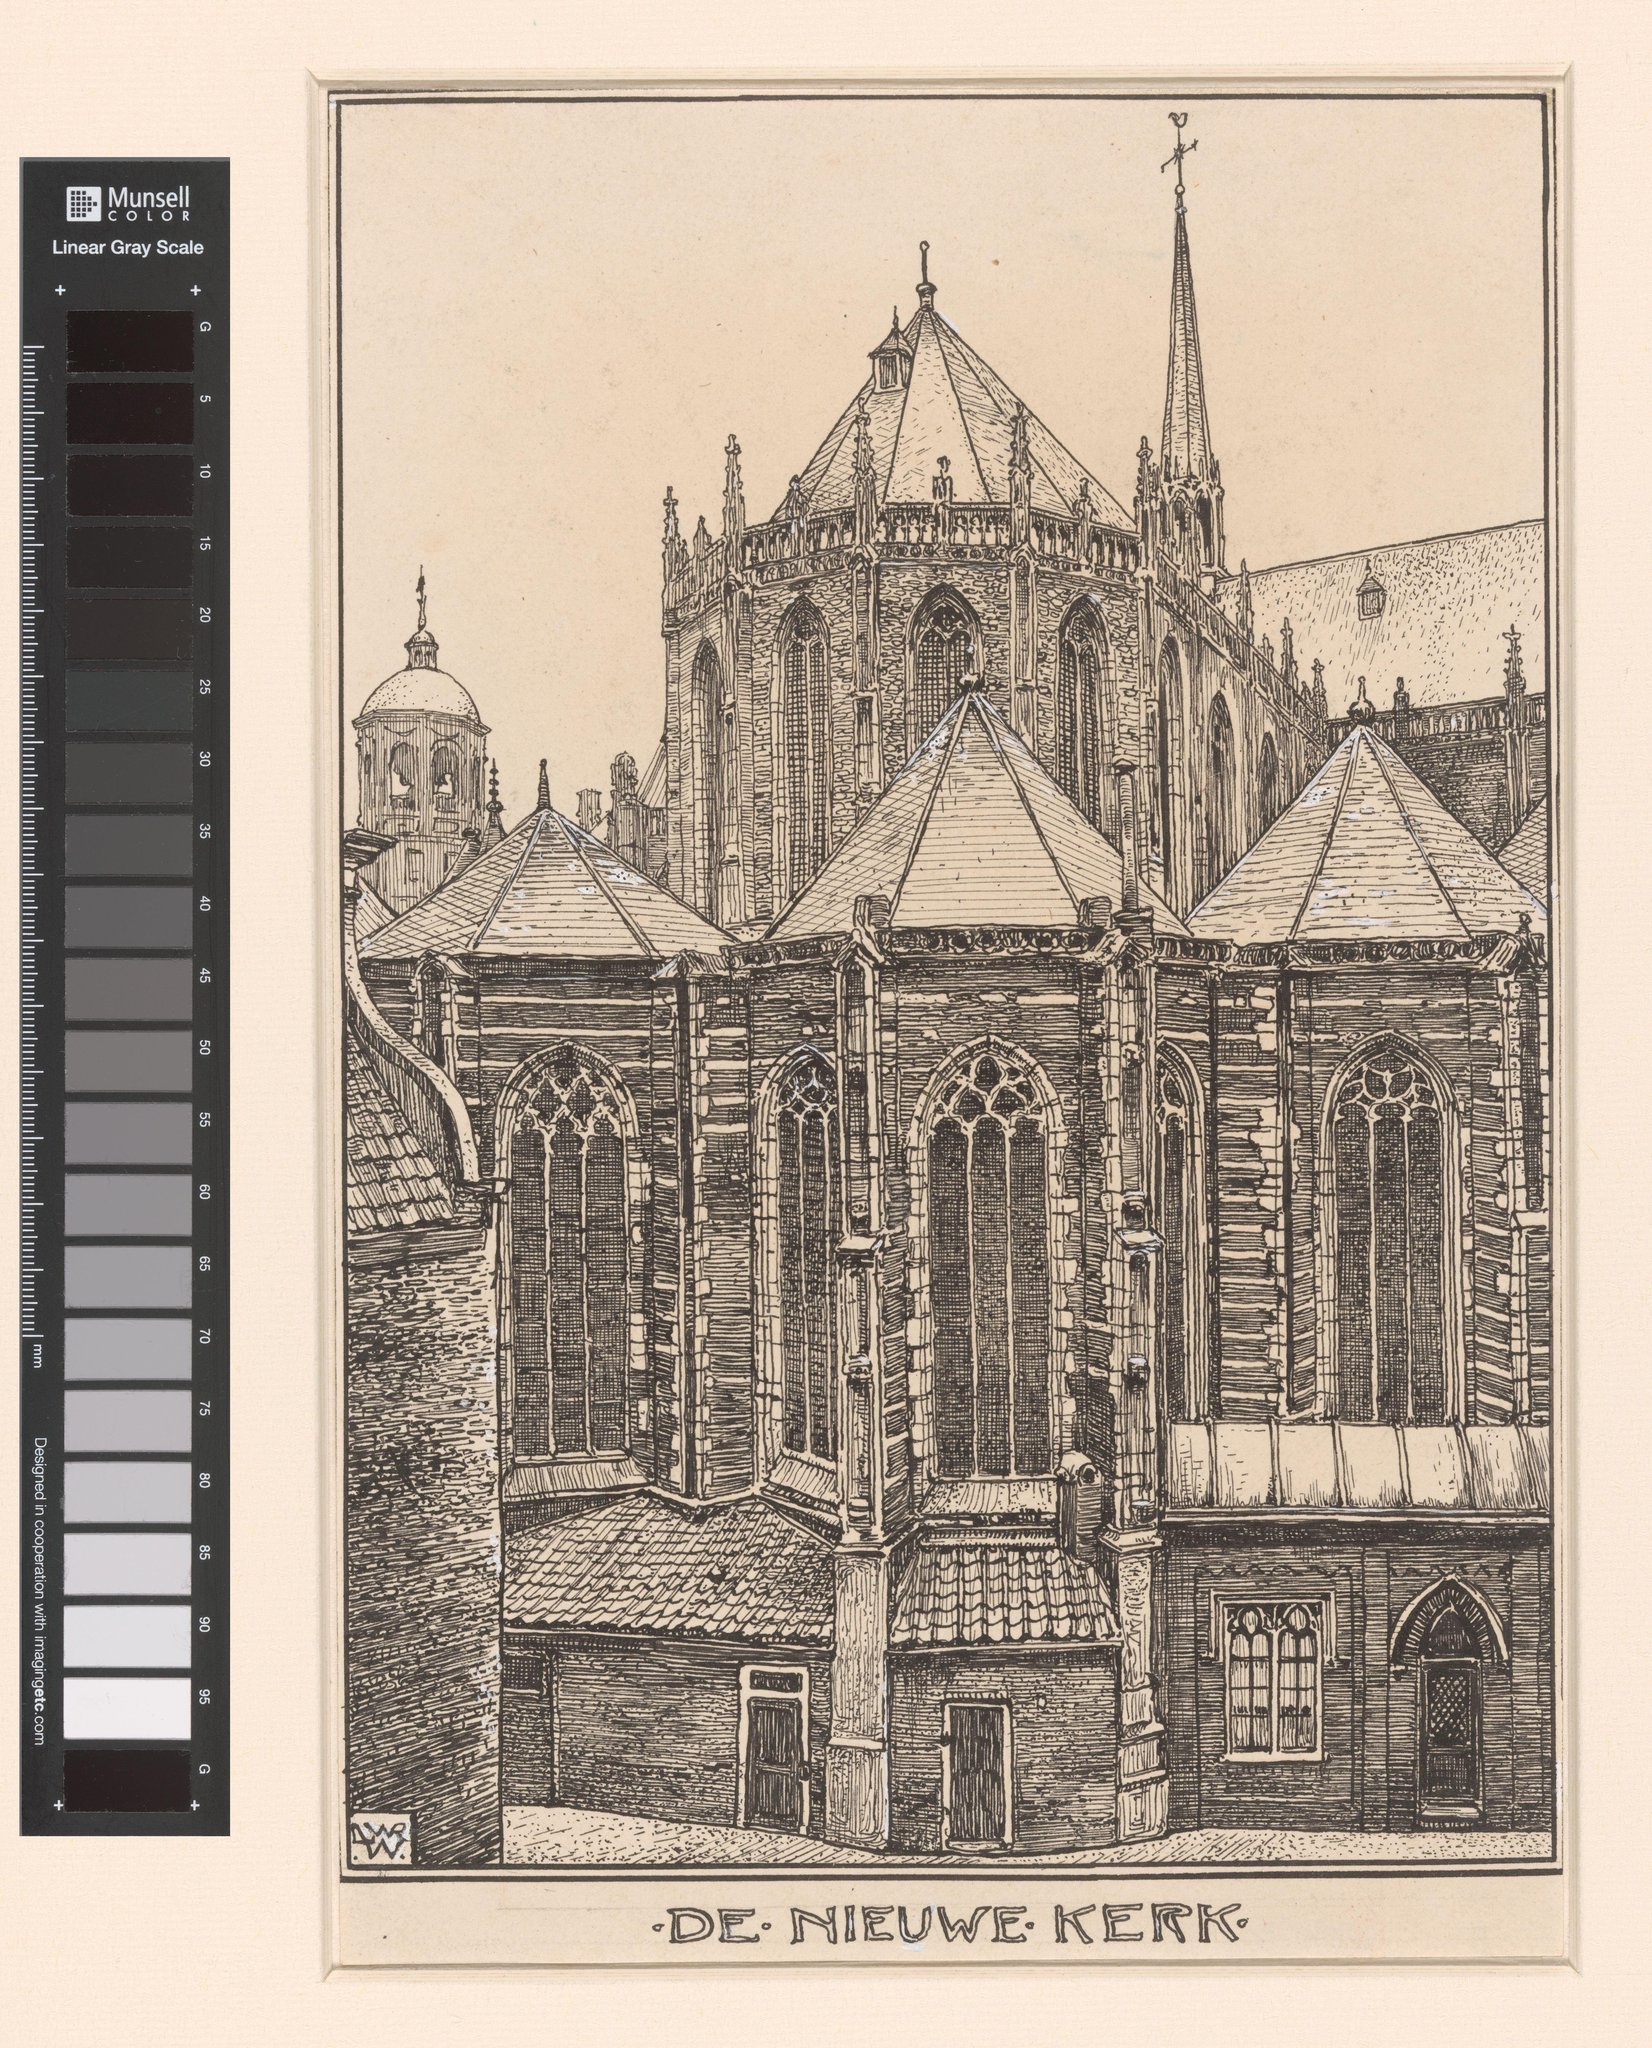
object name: drawing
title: Gezicht op het koor van de Nieuwe Kerk te Amsterdam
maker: willem wenckebach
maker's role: designer, draughtsman, painter, print maker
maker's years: 1860-1937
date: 1870-1926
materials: paint, ink, paper, pencil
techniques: pen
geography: amsterdam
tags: church (exterior)